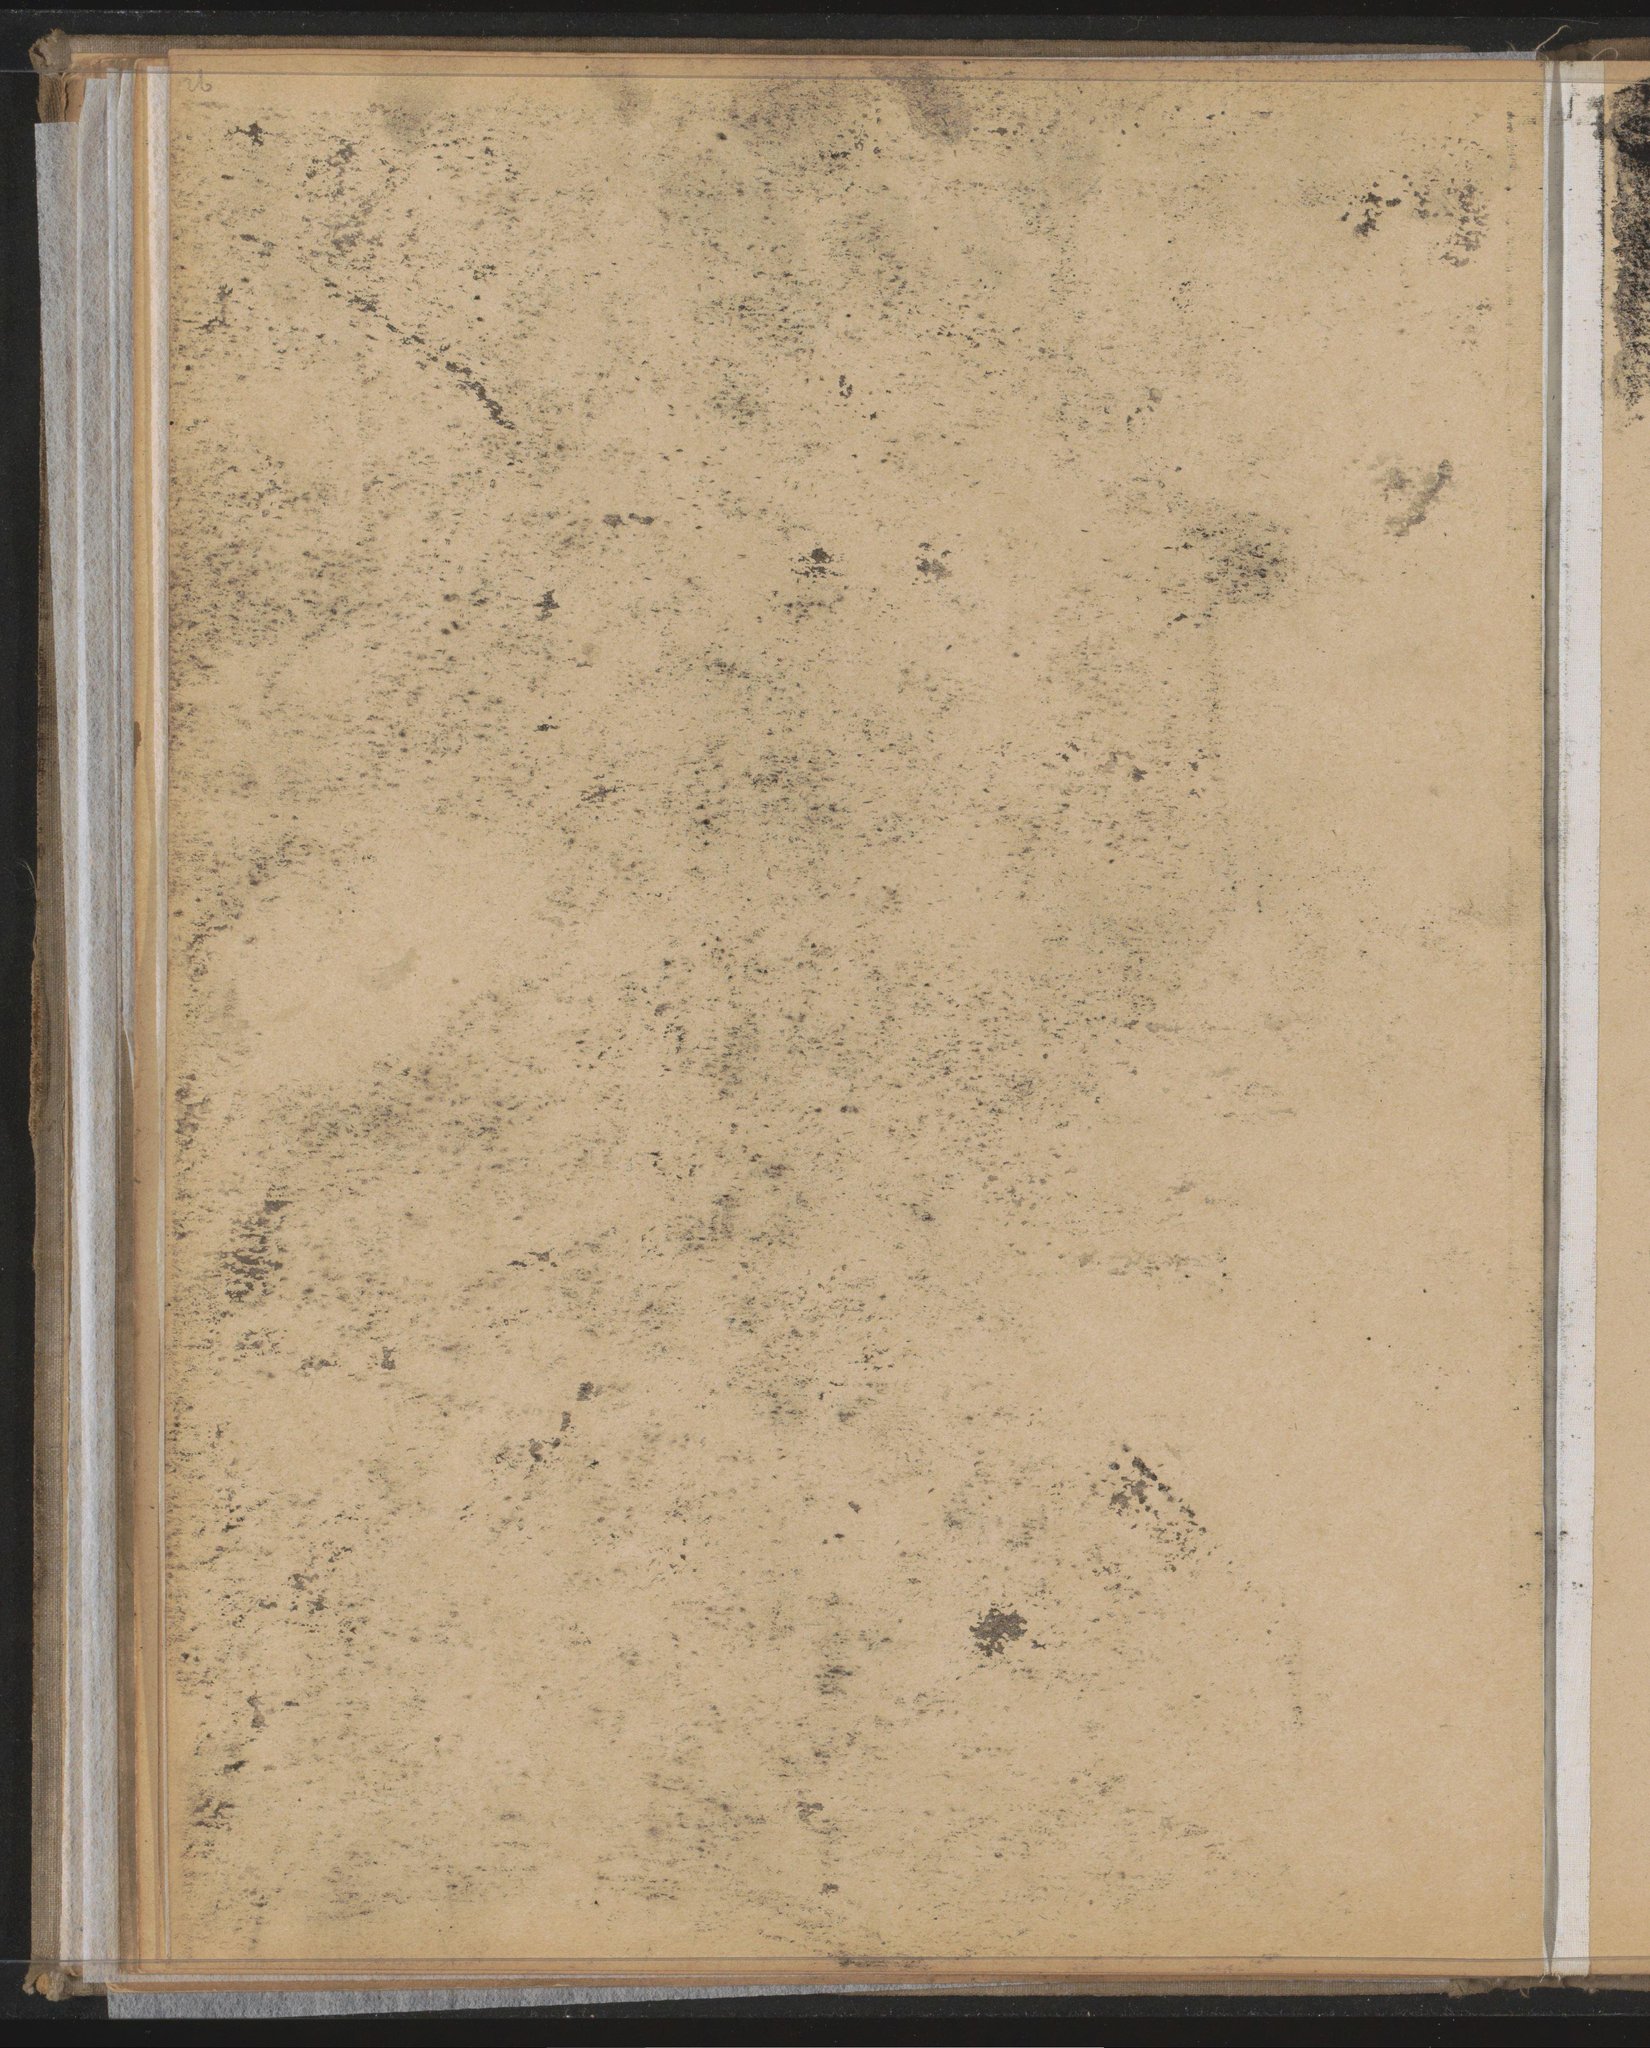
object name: sketchbook leaf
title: Abklatsch van de tekening op pagina 27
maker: willem witsen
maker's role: draughtsman, painter, print maker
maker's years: 1860-1923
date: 1893-1897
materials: paper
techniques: printmaking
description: Pagina 26 uit een schetsboek met 25 bladen.